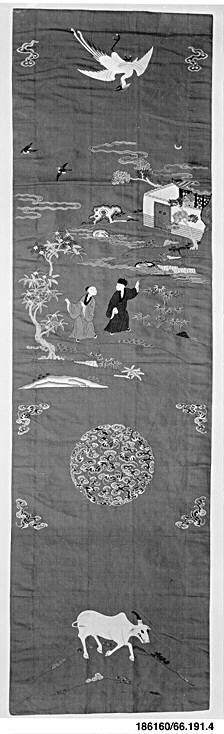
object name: chair strip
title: One of a Set of Twelve Chair Strips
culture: chinese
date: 1736-1795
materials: metal thread, silk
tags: human figures,animals,birds,trees